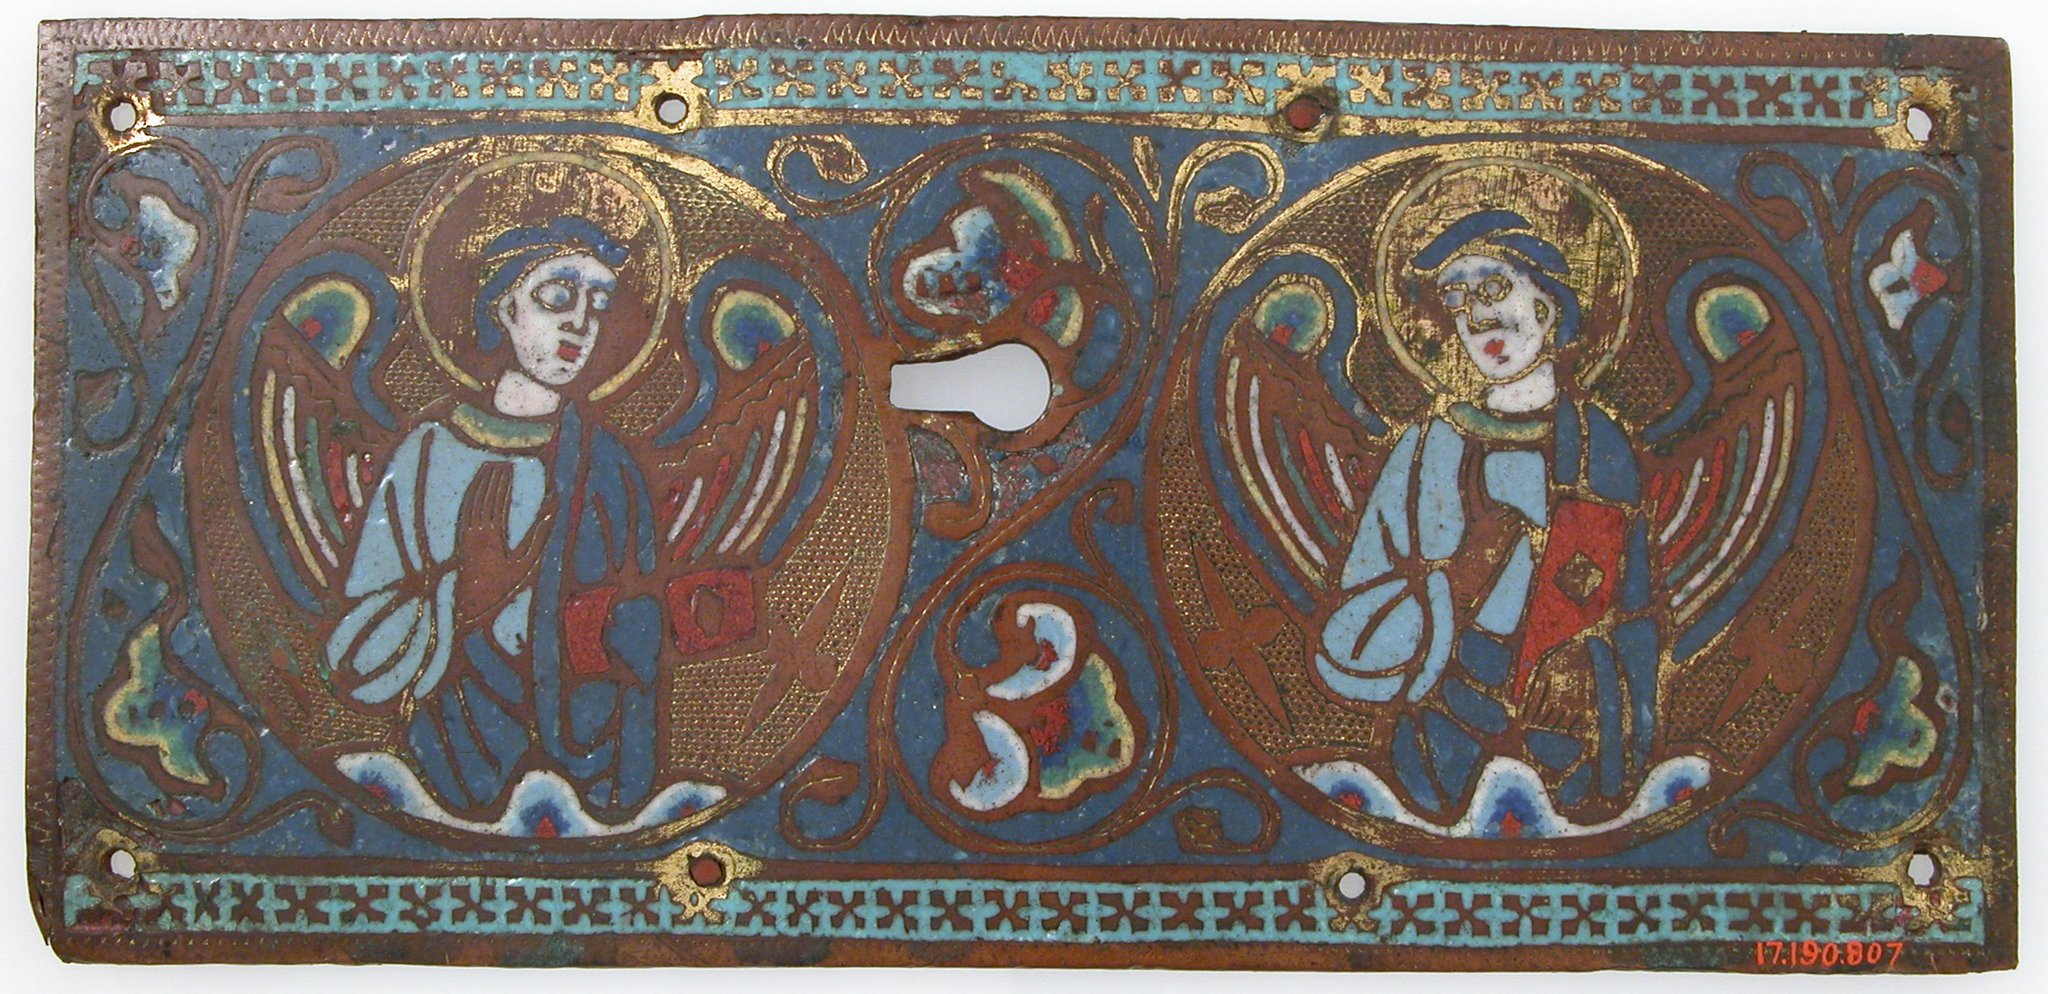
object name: plaque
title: Plaque from a Chasse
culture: french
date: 1201-1300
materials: gilt copper, enamel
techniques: enamel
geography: france